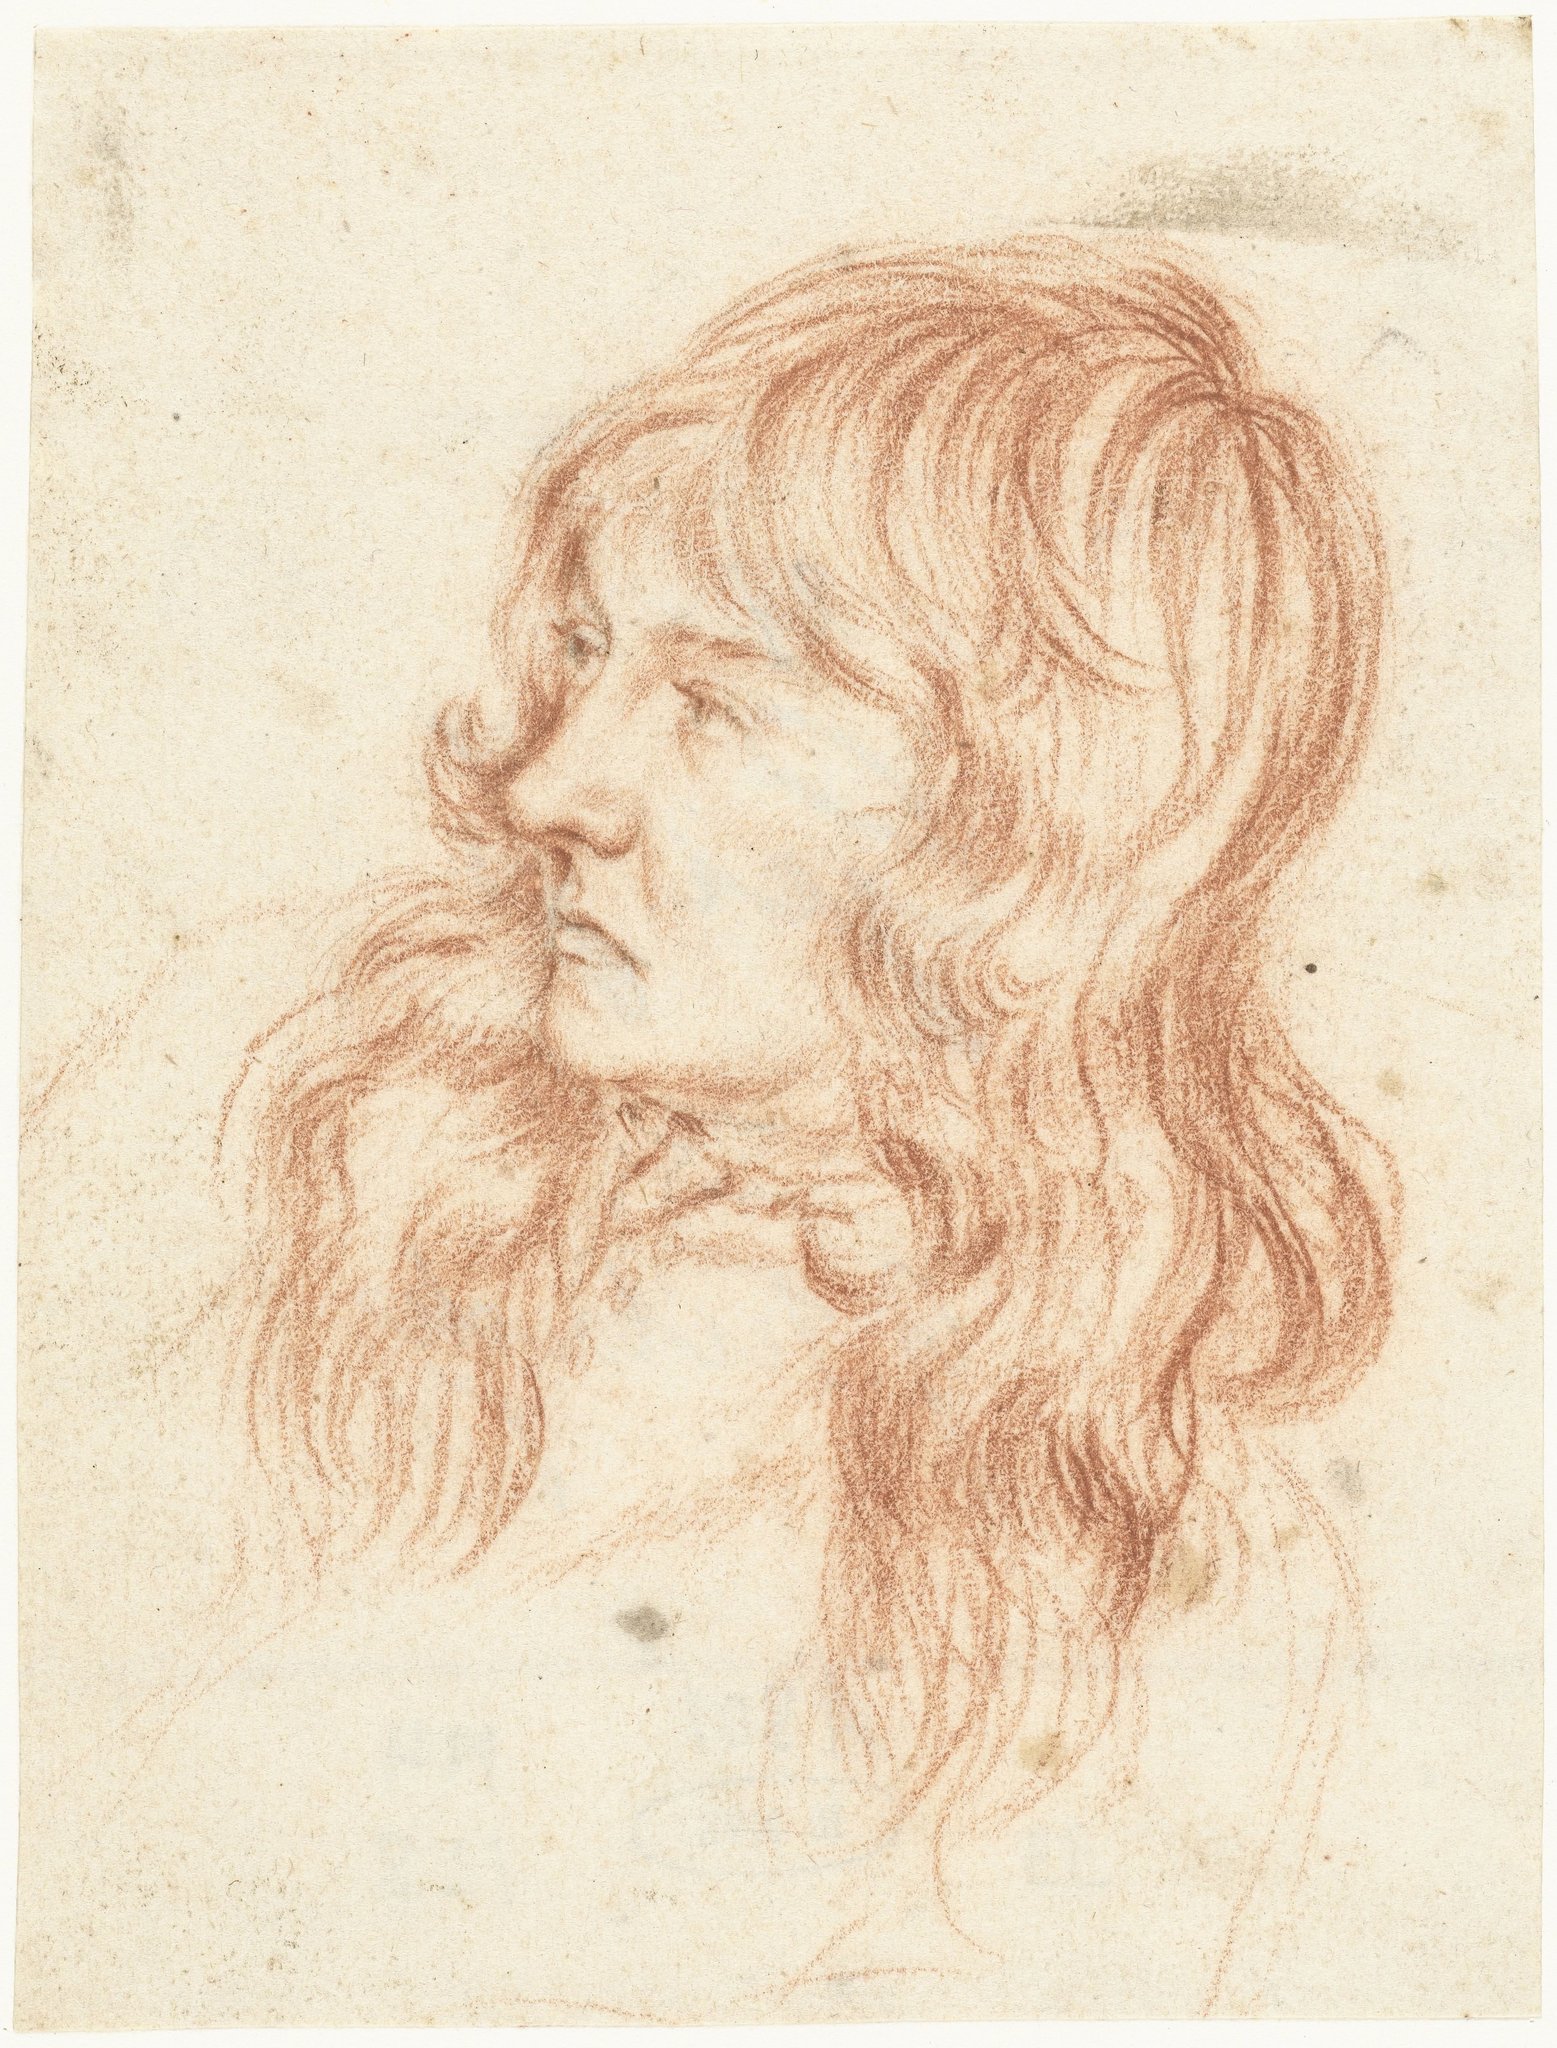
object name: drawing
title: Hoofd van een jongeman, naar links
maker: gerard ter borch (ii)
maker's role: draughtsman, painter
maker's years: 1617-1681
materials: chalk, paper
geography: deventer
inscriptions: signature: ‘Ger.Jr. ; G.Terborch’